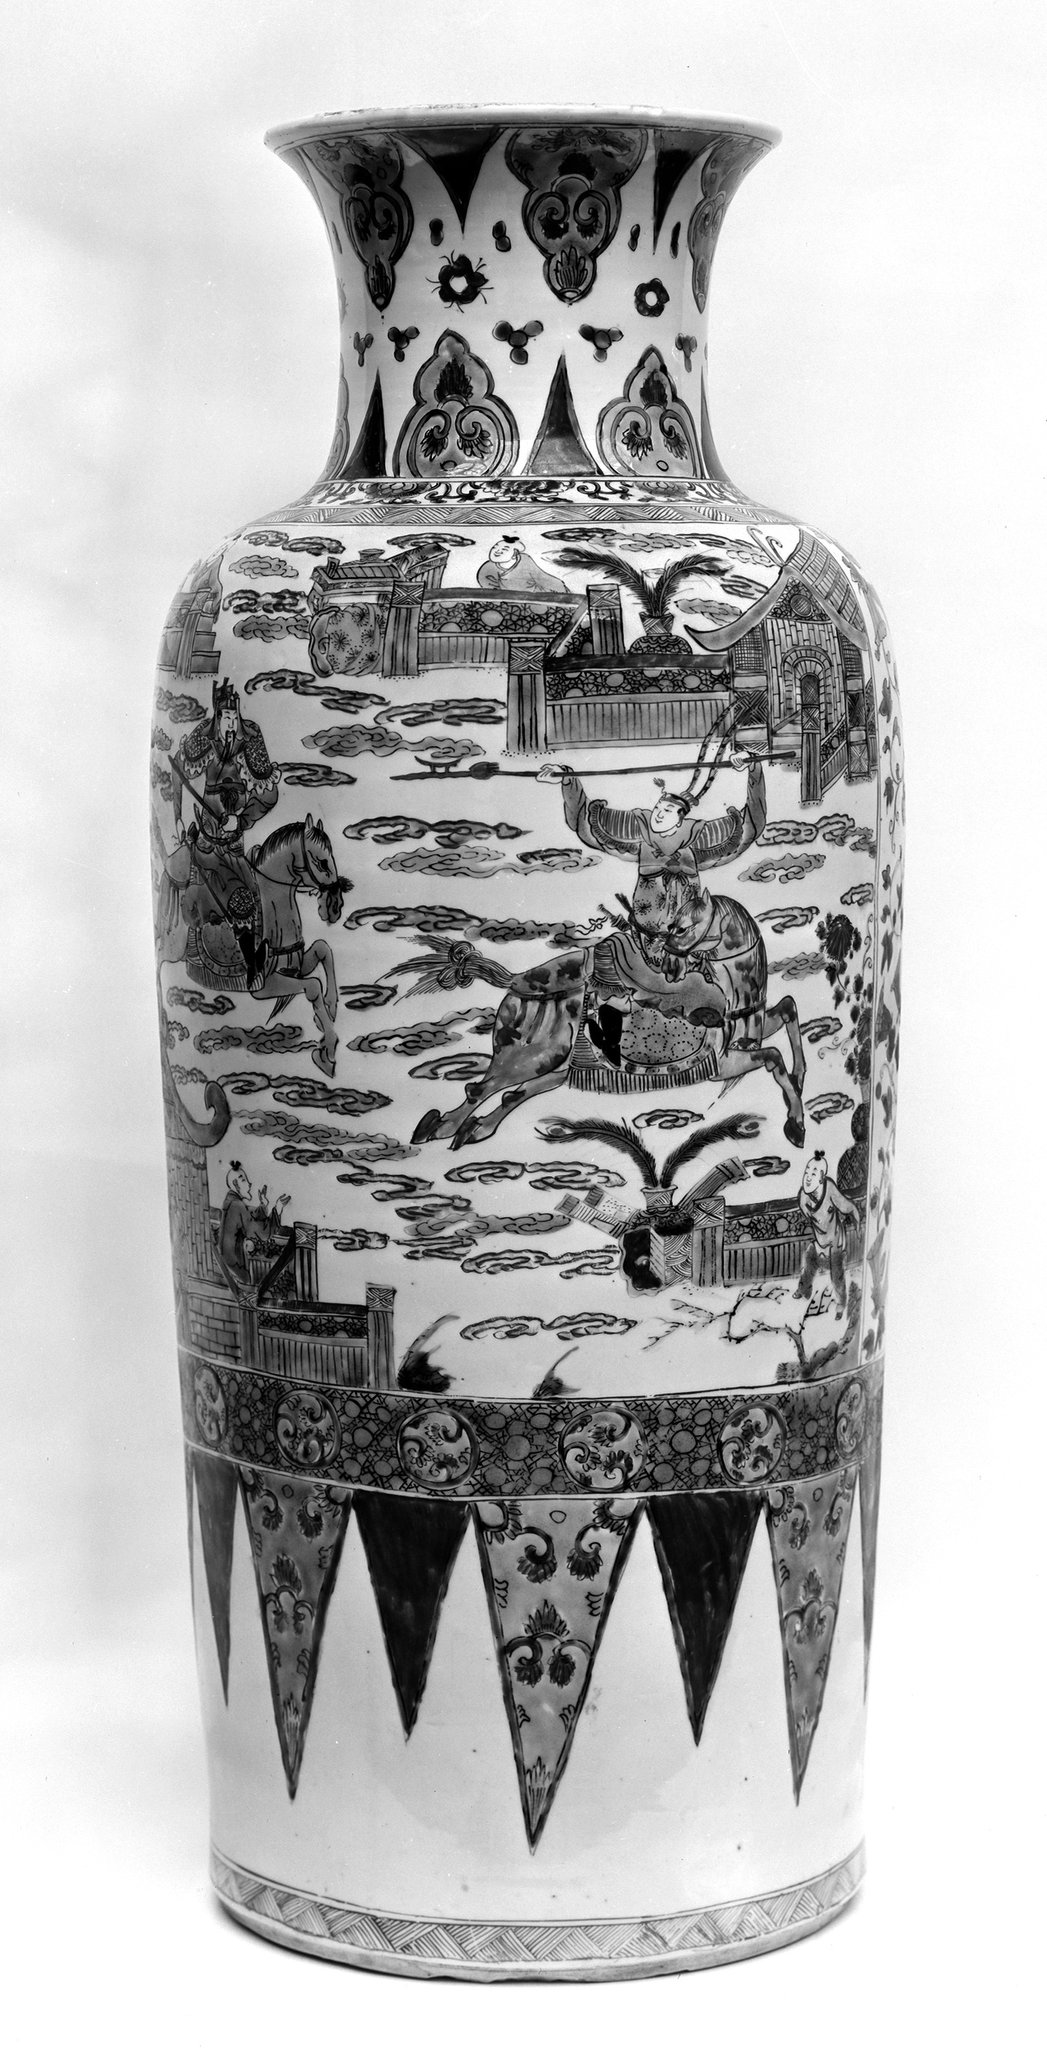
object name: vase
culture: chinese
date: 1662-1722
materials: enamel, porcelain